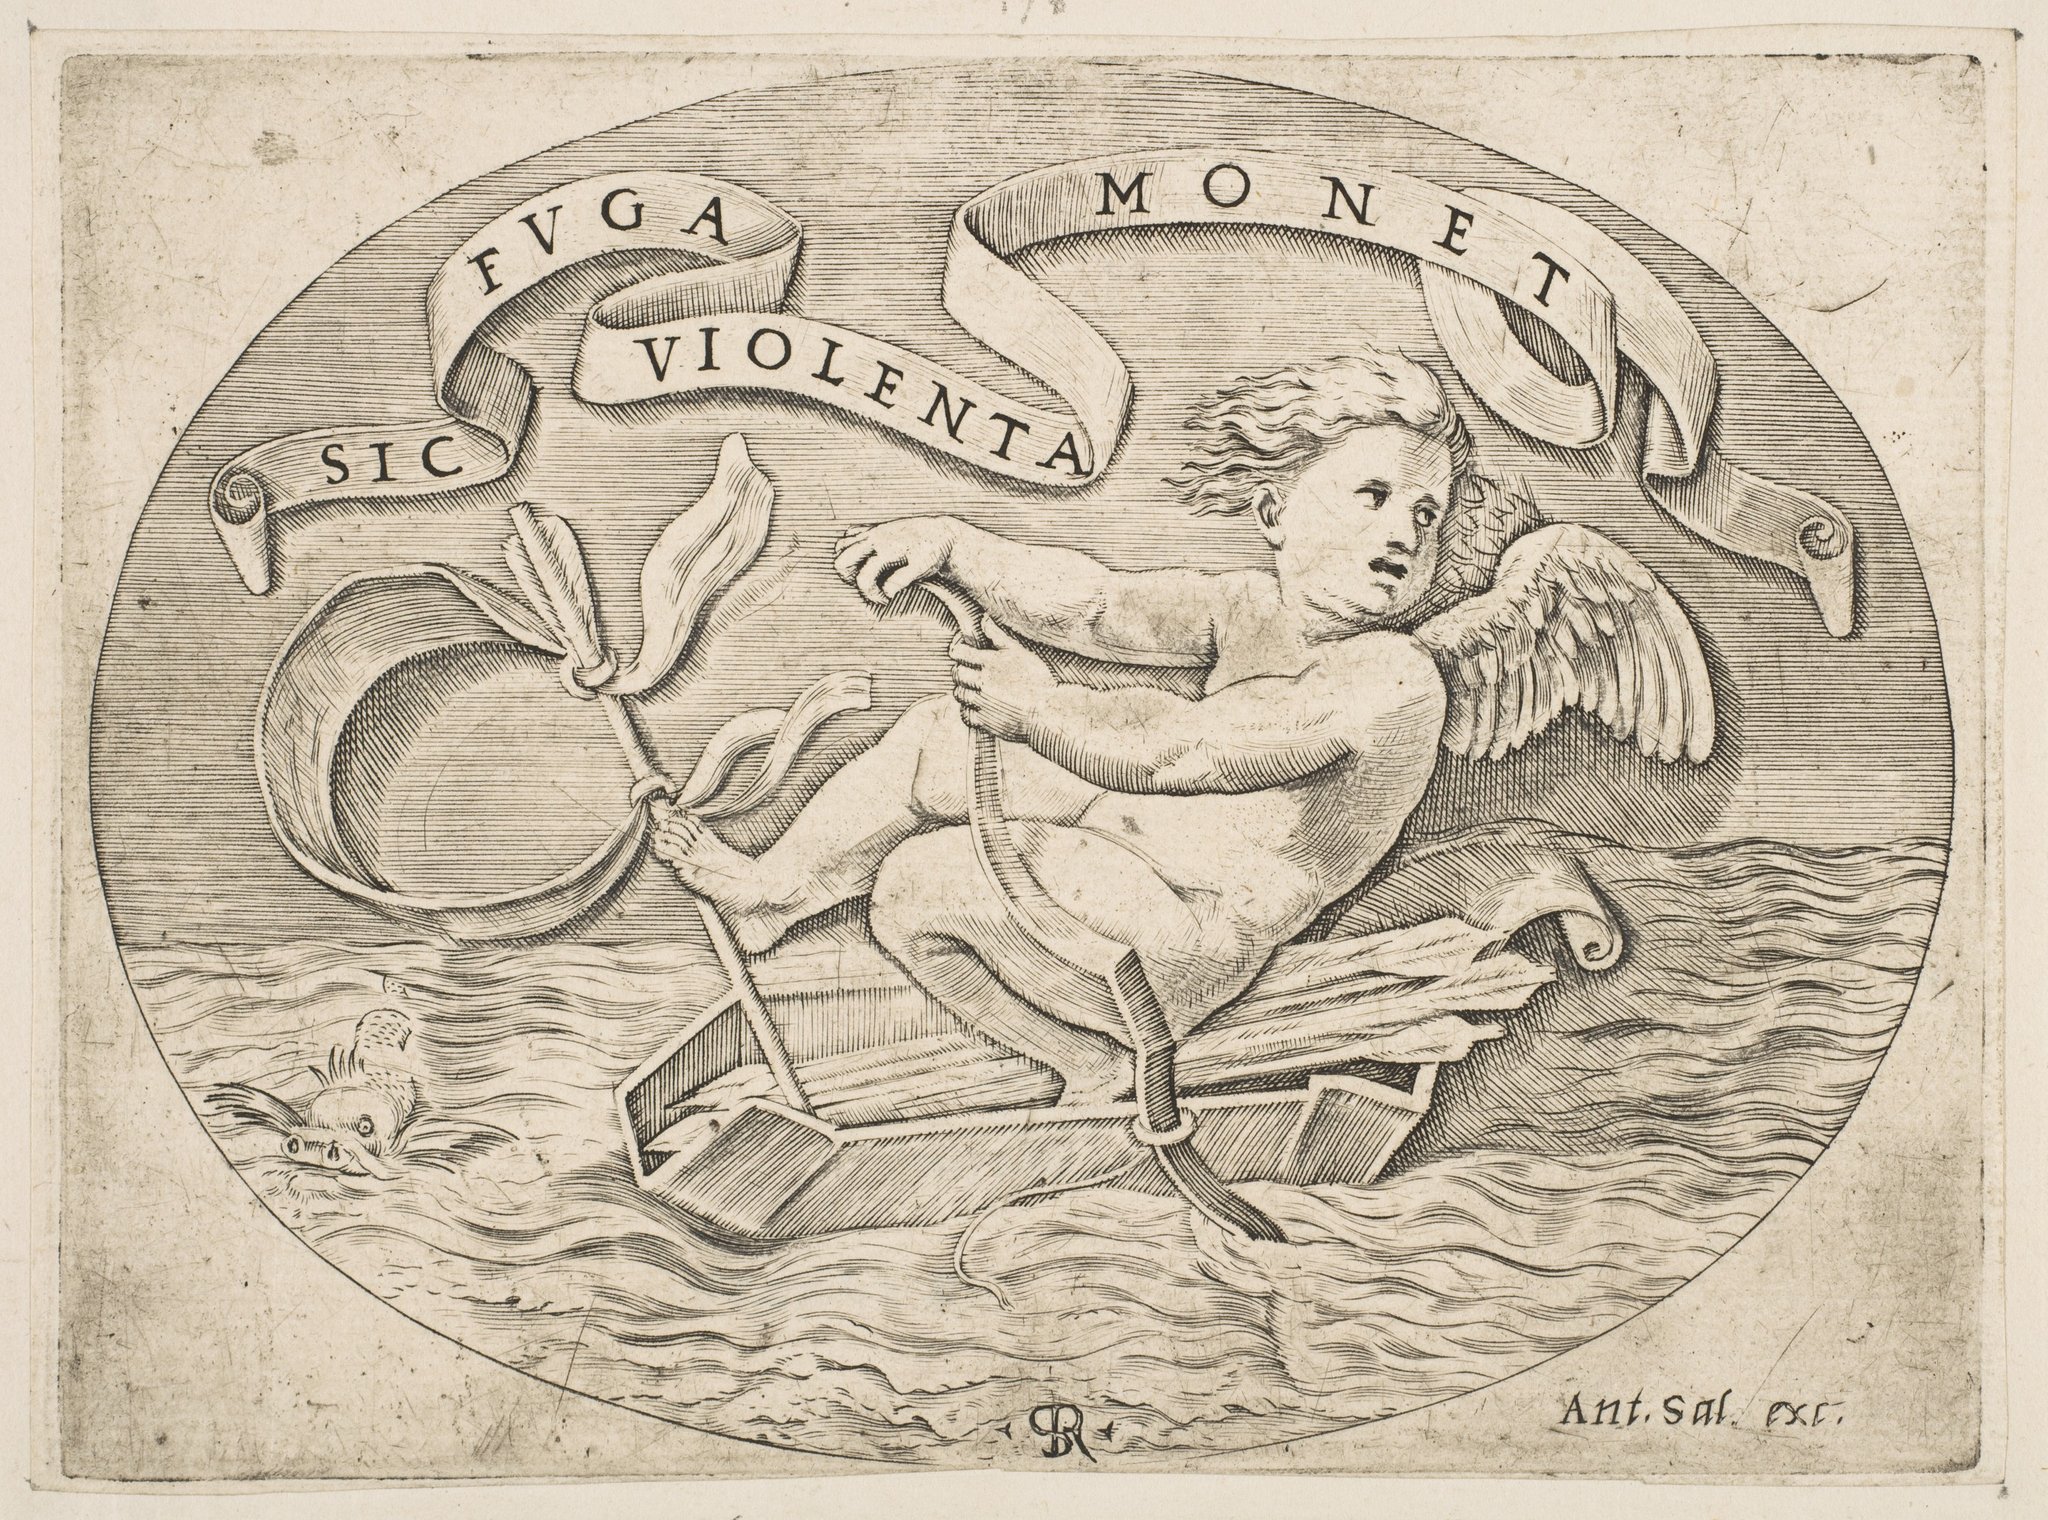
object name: print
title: Eros Escaping by Sea; Cupid using his bow to propel a boat made from his quiver with an arrow as the mast and his blindfold as the sail, a banderole above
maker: marco dente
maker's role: artist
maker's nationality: italian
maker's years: 1515-1527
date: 1515-1527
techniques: engraving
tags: cupid,eros,boats